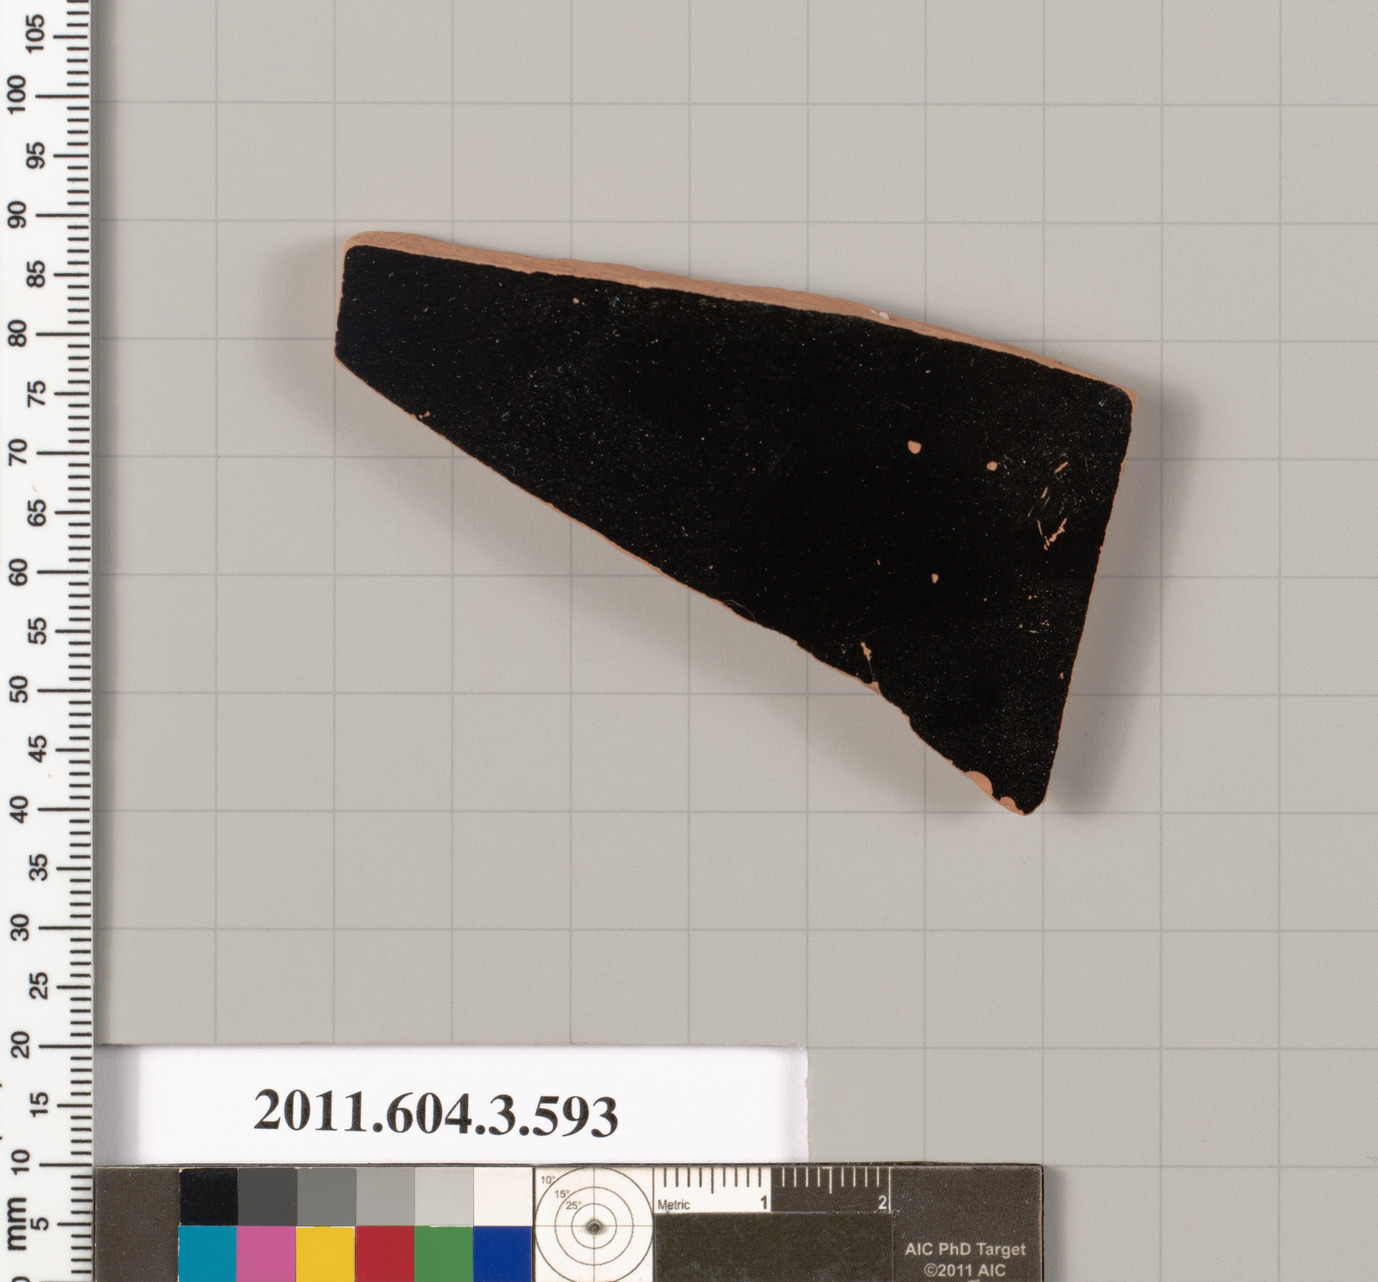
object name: calyx krater or column krater fragment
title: Terracotta fragment of a column-krater (bowl for mixing wine and water) or calyx-krater (bowl for mixing wine and water)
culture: greek, attic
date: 600-401 BCE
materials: terracotta